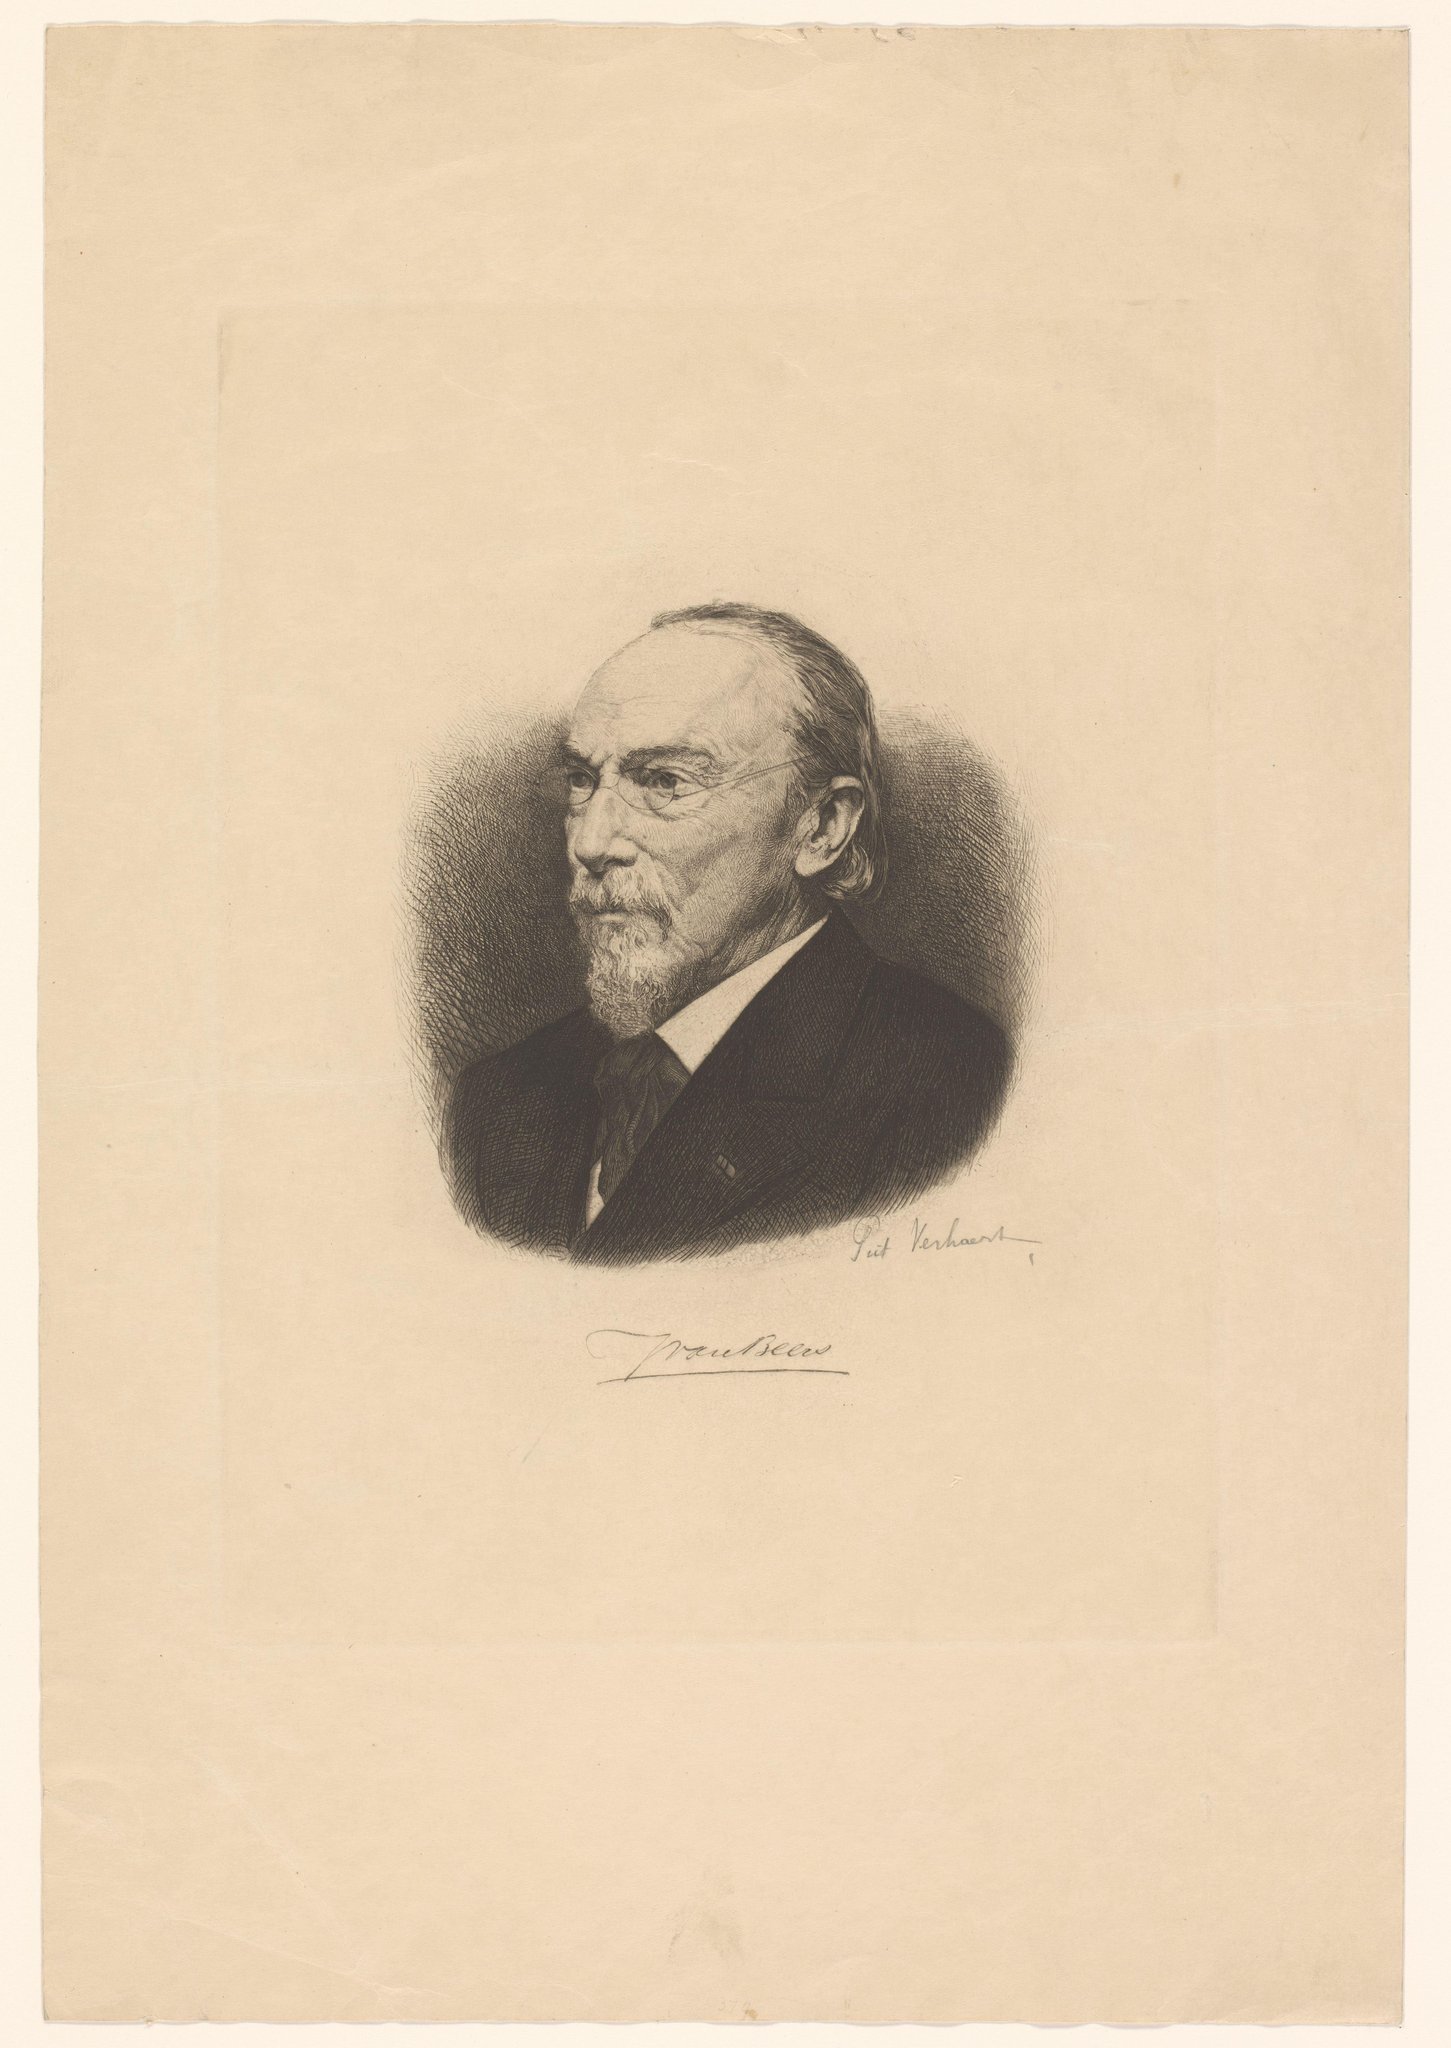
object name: print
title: J vanBeers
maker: piet verhaert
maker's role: print maker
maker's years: 1852-1908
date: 1862-1903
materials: paper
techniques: etching, intaglio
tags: eyeglasses, spectacles, historical persons, old man, beard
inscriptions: collector's mark: Lugt 2228